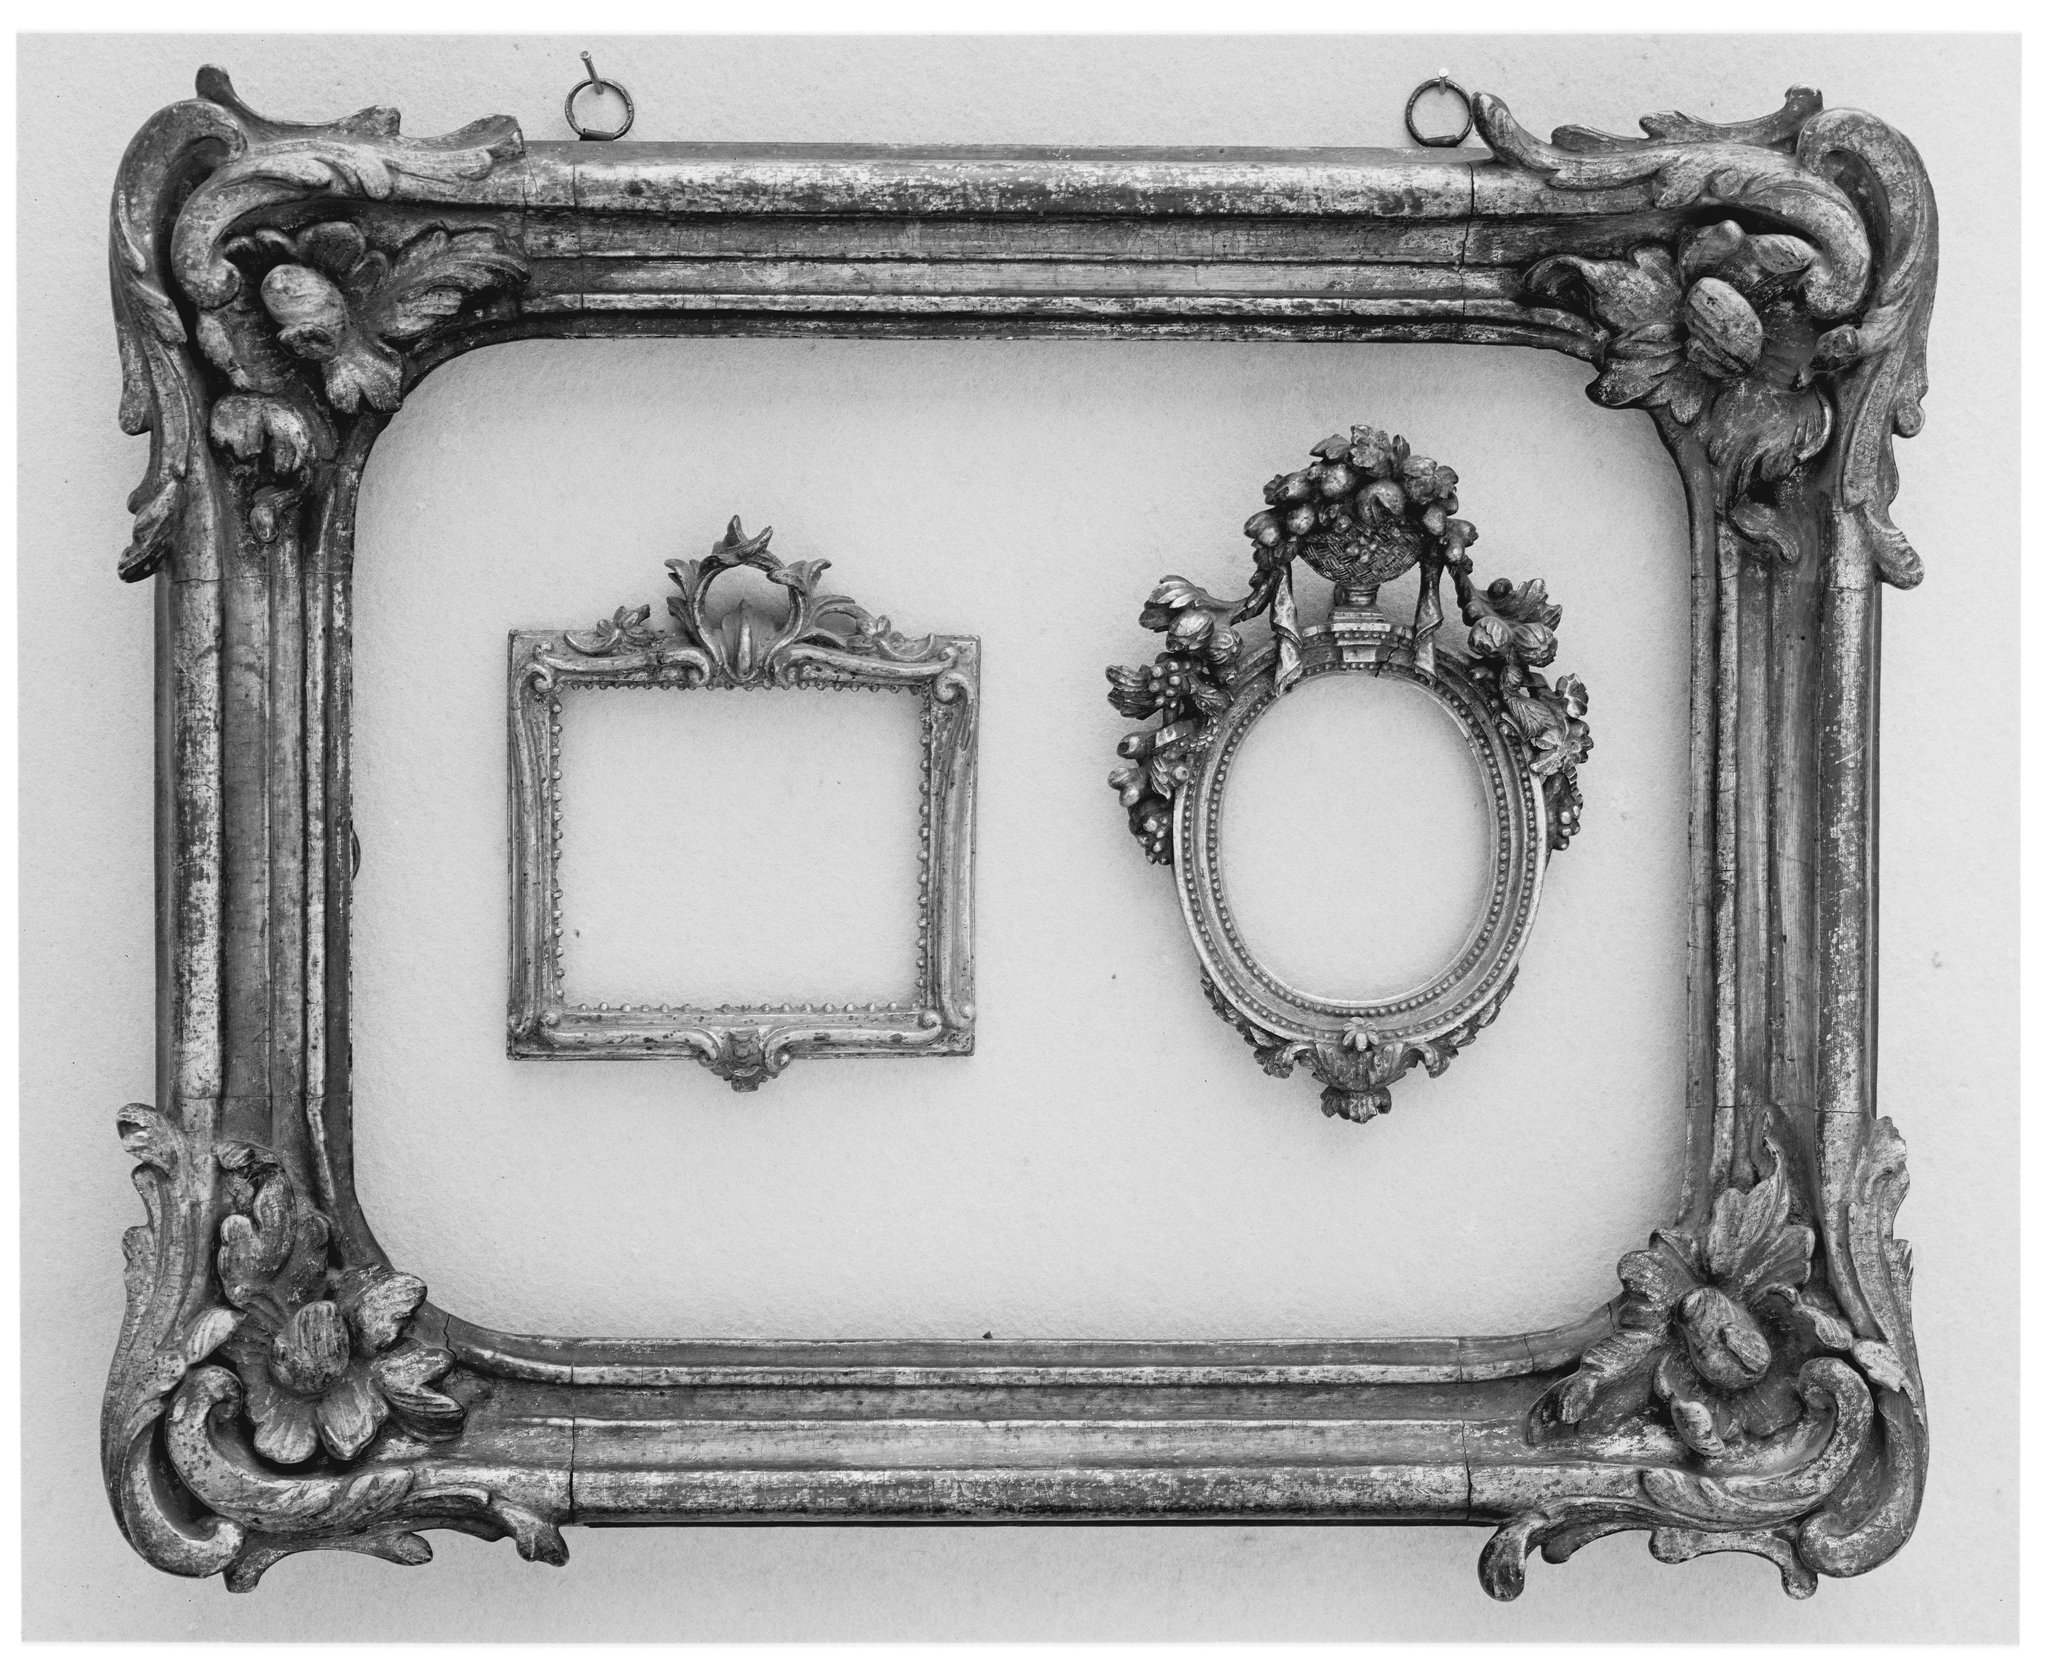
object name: frame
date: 1701-1800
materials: wood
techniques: carving, gilding